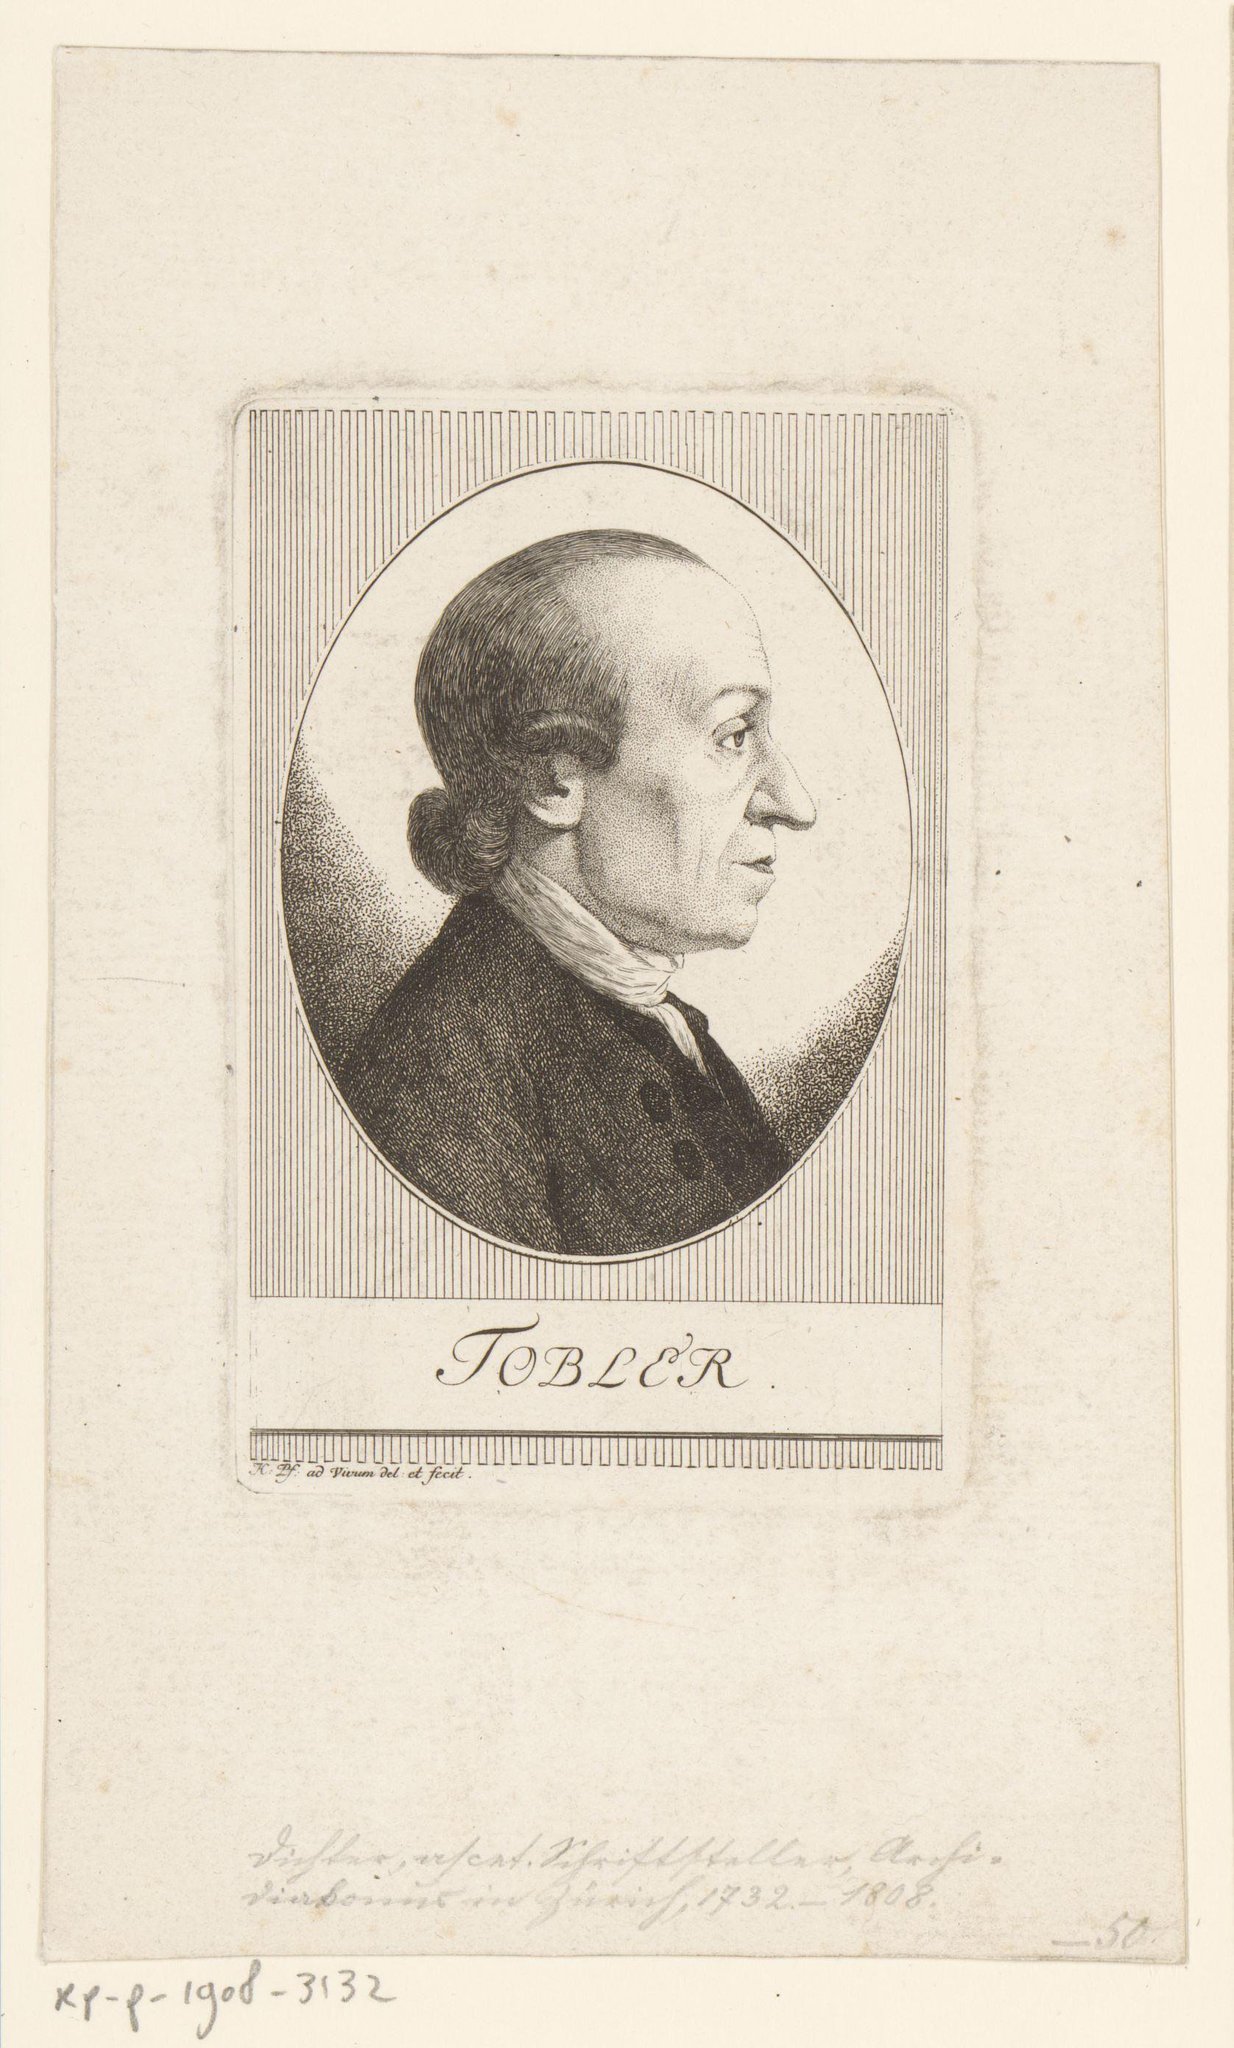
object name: print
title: Portret van Johann Tobler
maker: heinrich pfenninger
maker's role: print maker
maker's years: 1749-1815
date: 1759-1815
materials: paper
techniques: etching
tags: historical persons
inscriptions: collector's mark: Lugt 2228